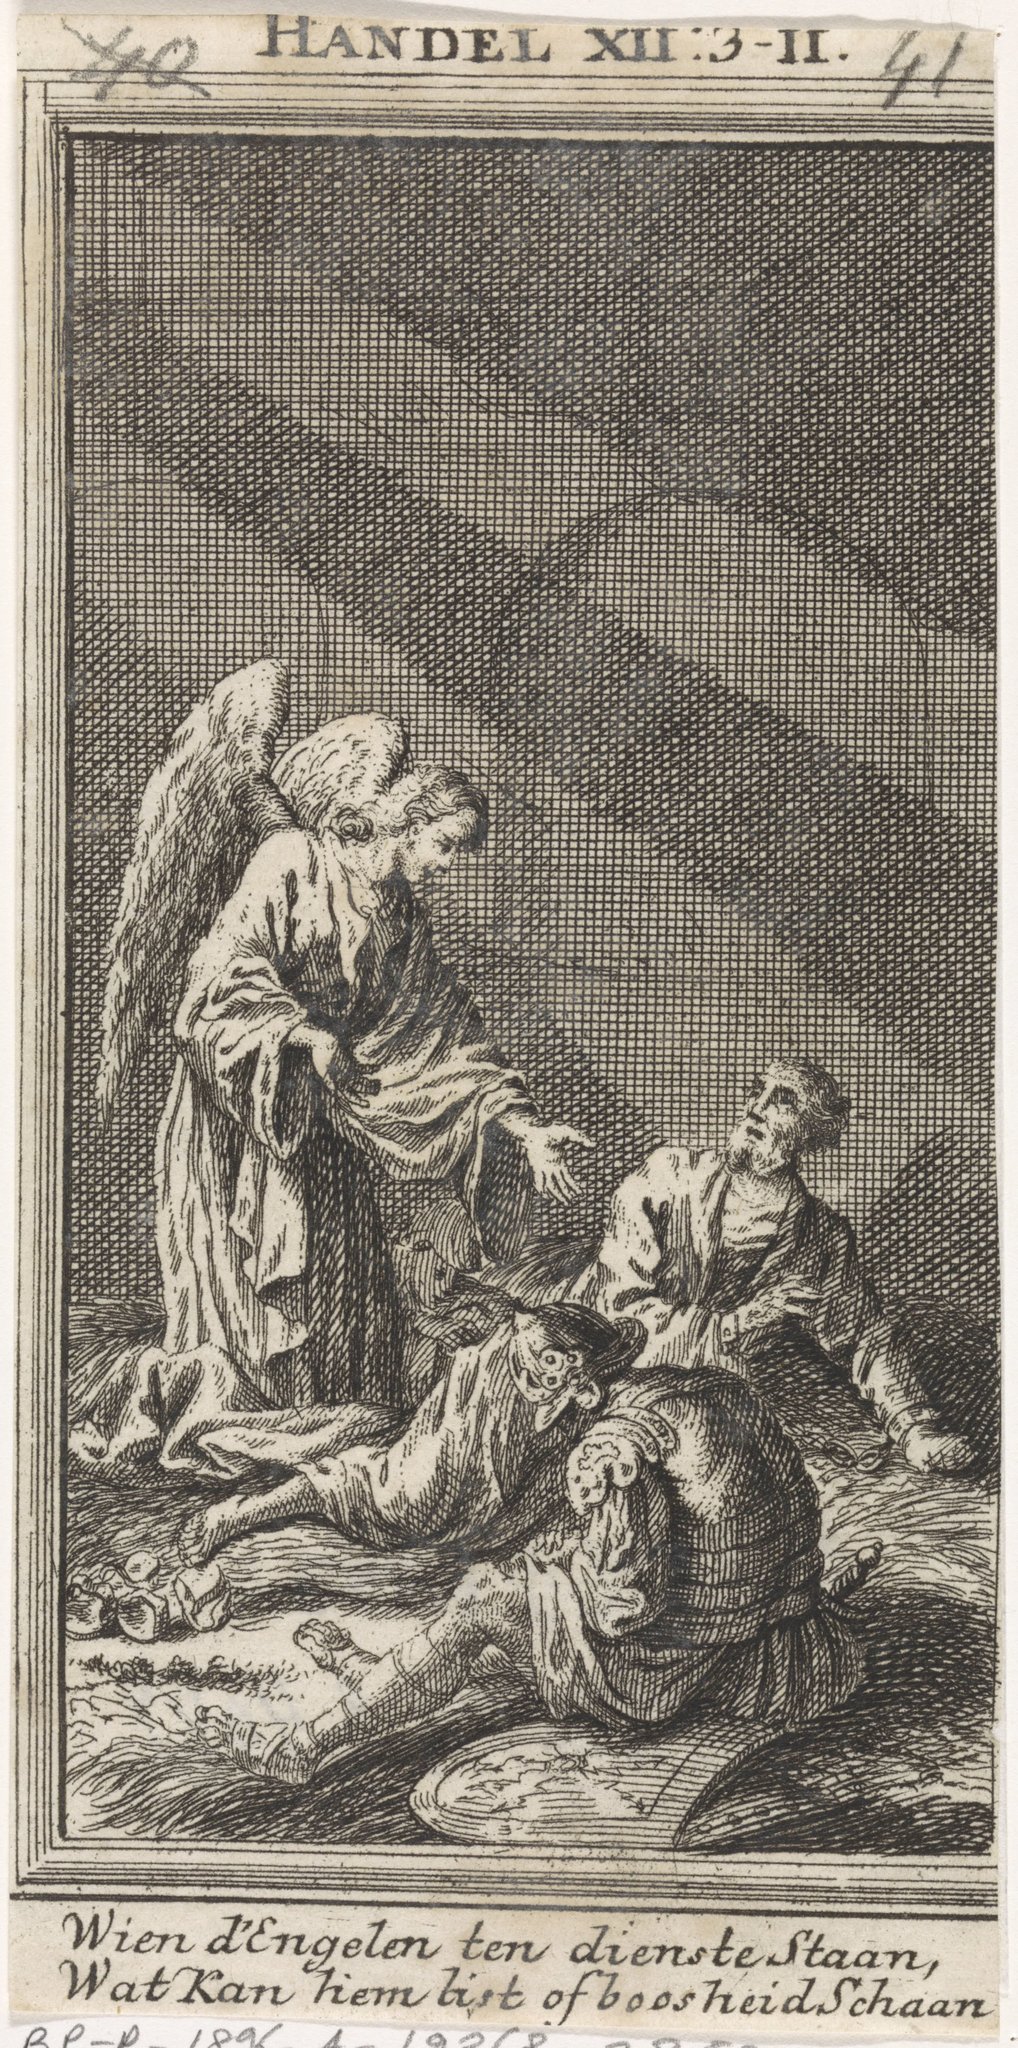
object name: print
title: Bevrijding van Petrus uit de gevangenis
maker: Anonymous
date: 1712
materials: paper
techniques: etching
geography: amsterdam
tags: the angel leads peter past the sleeping guards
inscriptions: collector's mark: Lugt 2228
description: Kopie van illustratie voor: Luyken, Jan. Bybel printen. Amsterdam: Pieter Arentsz. II (wed.) en Cornelis van der Sys, 1712, p. 40.